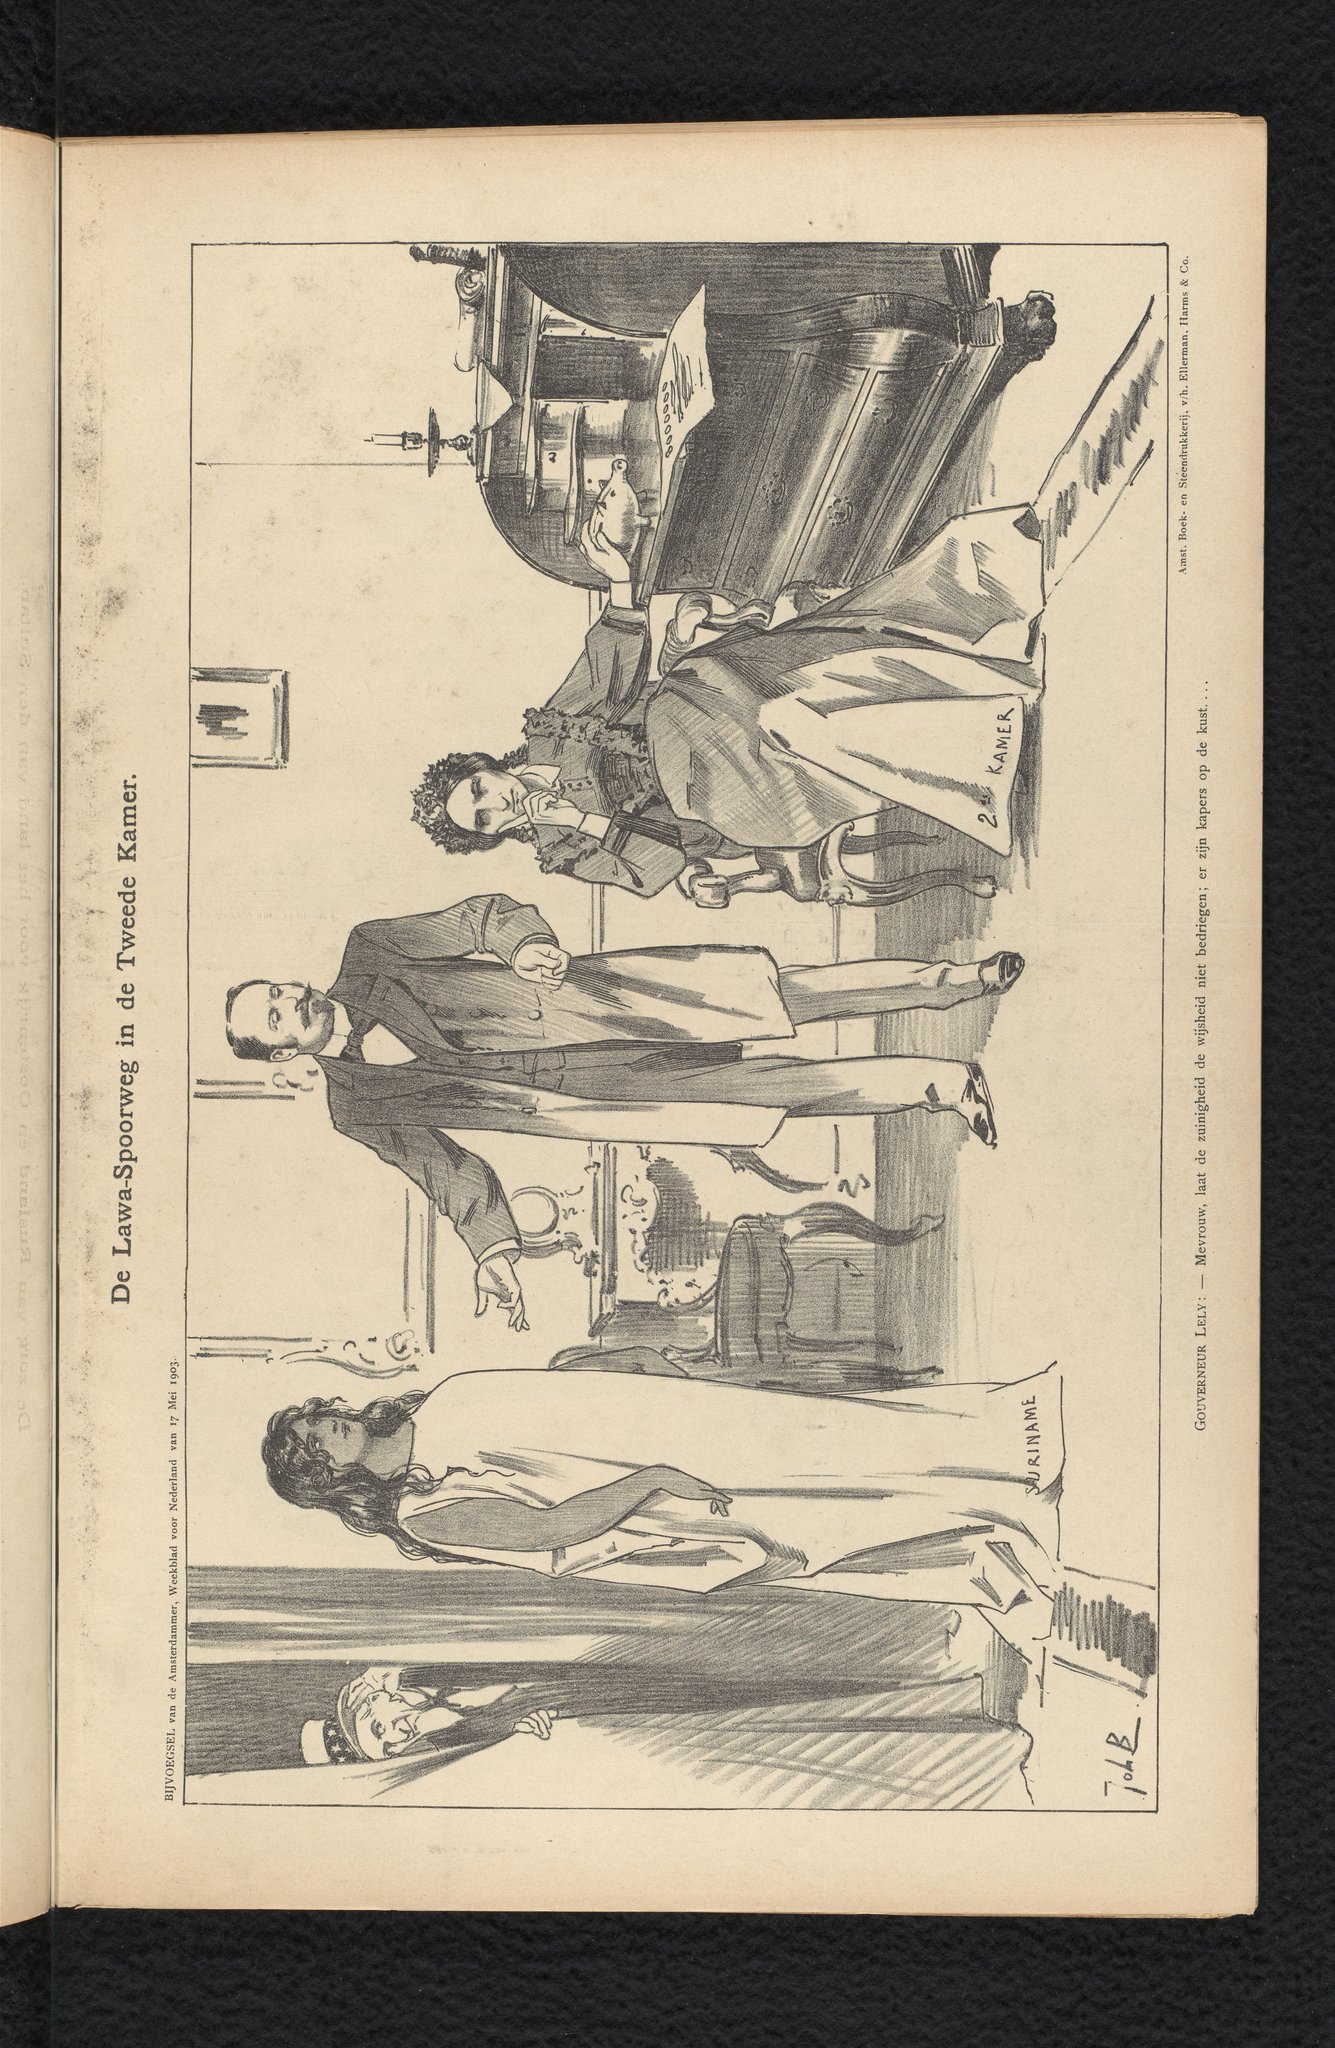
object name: cartoon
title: De Lawa-Spoorweg in de Tweede Kamer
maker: johan braakensiek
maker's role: draughtsman, print maker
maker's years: 1858-1940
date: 1903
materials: paper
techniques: lithograph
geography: netherlands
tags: amsterdam, the hague, politician, colonial governor, railway, train, political caricatures and satires, suriname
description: De gouverneur van Suriname Cornelis Lely bepleit aan de personificatie van de Tweede Kamer, een vrouw met haar hand op de spaarpot, de aanleg van de Lawaspoorweg in Suriname. Suriname is hier gepersonifieerd als een jonge zwarte vrouw. Achter een gordijn luistert Uncle Sam (Verenigde Staten) het gesprek af.